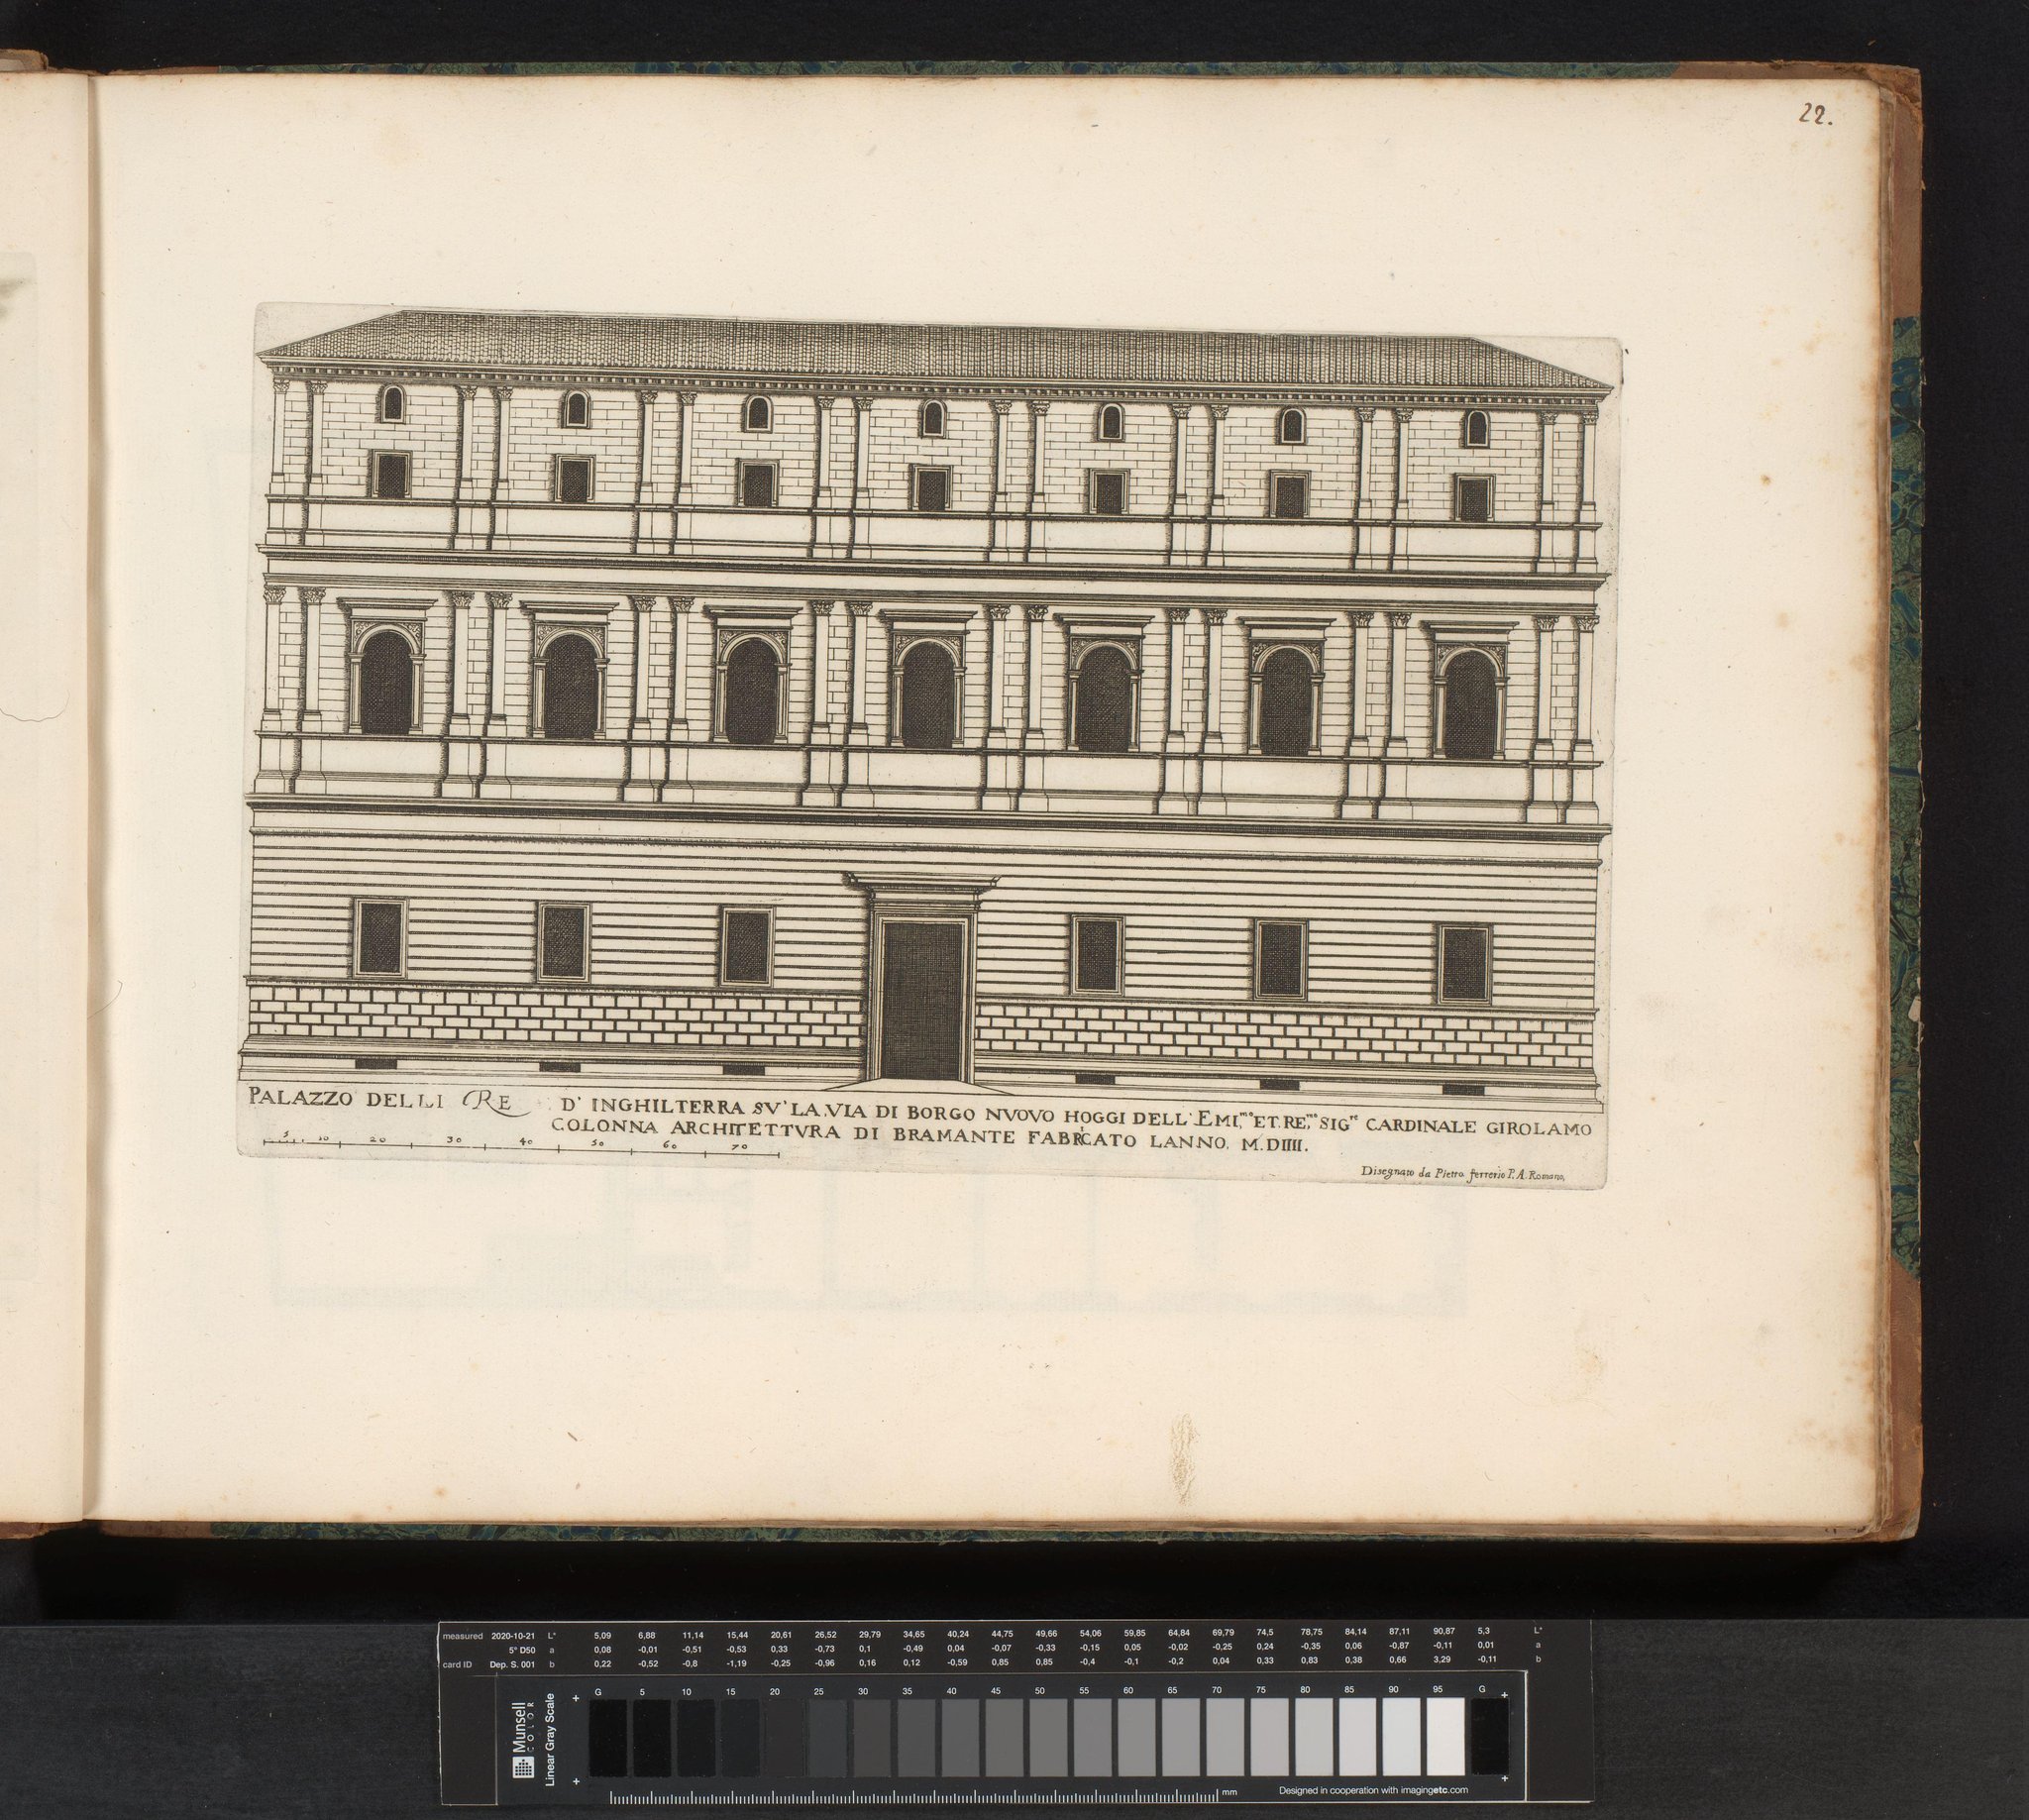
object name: print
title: Palazzi di Roma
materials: paper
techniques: etching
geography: rome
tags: palace, façade (of house or building)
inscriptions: number: ‘22’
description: Deze prent maakt deel uit van de reeks getiteld: Palazzi di Roma. Deze reeks bestaat uit twee boeken. Boek één getiteld: Palazzi di Roma dei più celebri architetti..., bestaat uit 44 prenten die worden toegeschreven aan Giovanni Battista Falda (naam staat enkel op prent 27) en uitgegeven door Giovanni Giacomo de'Rossi. Deze 44 prenten zijn bekend in twee staten (met en zonder nummer). Boek twee getiteld: Nuovi disegni dell'architetture... libro secondo, bevat 66 prenten door Giovanni Battista Falda en Simone Felice. Deze 66 prenten zijn bekend in twee staten (met en zonder nummer).